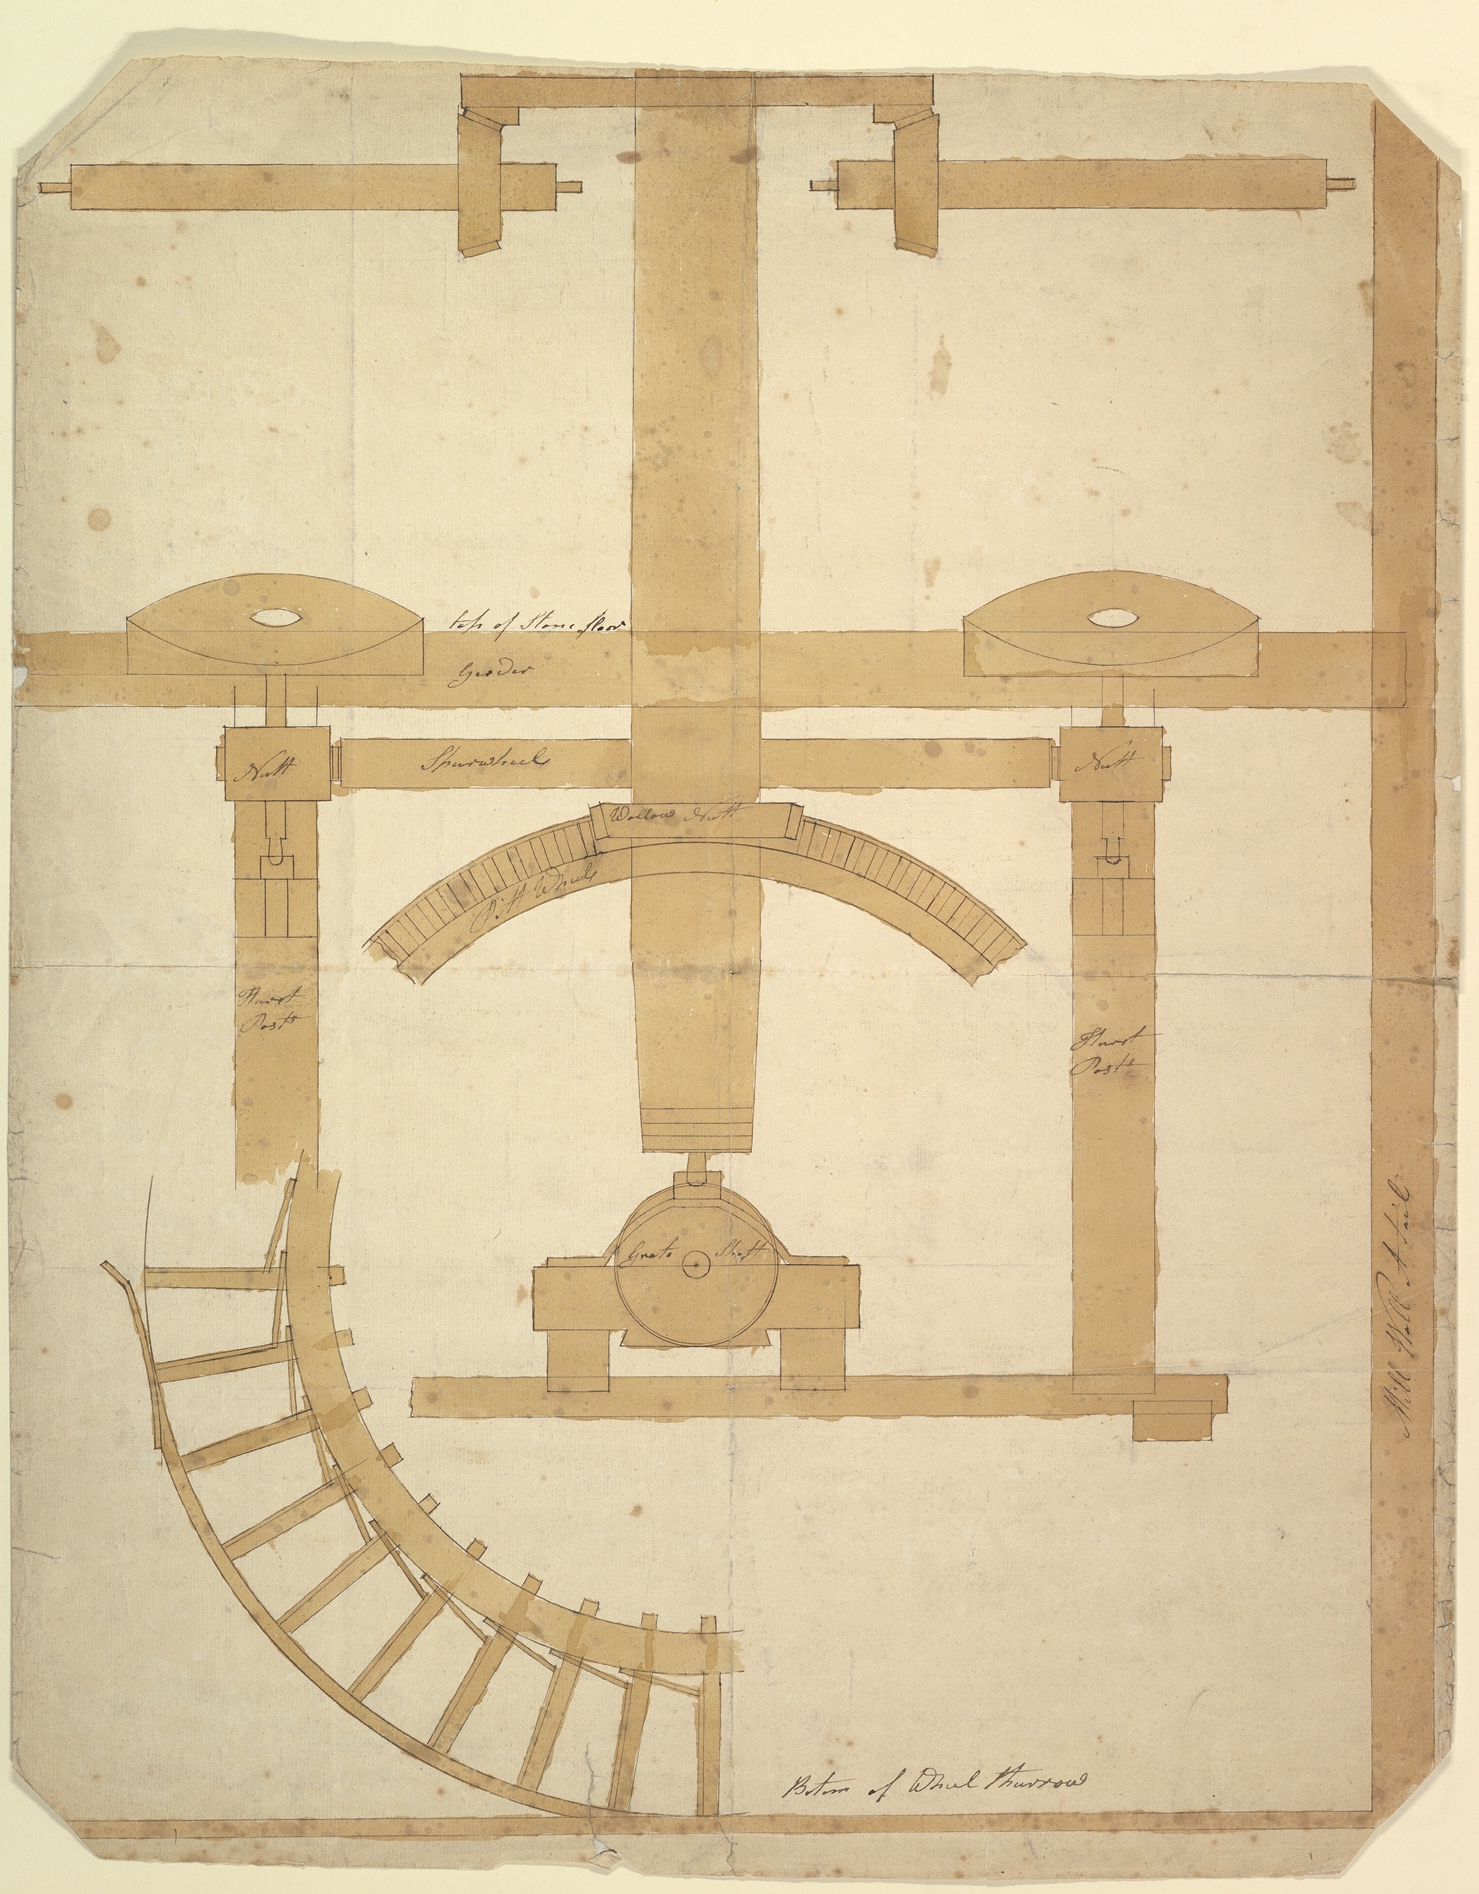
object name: drawing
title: Plan of the Operating Gear of a Mill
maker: anonymous, british, 18th century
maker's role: artist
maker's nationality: british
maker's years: 1700-1800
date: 1701-1800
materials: ink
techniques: brush, pen, wash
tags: machines